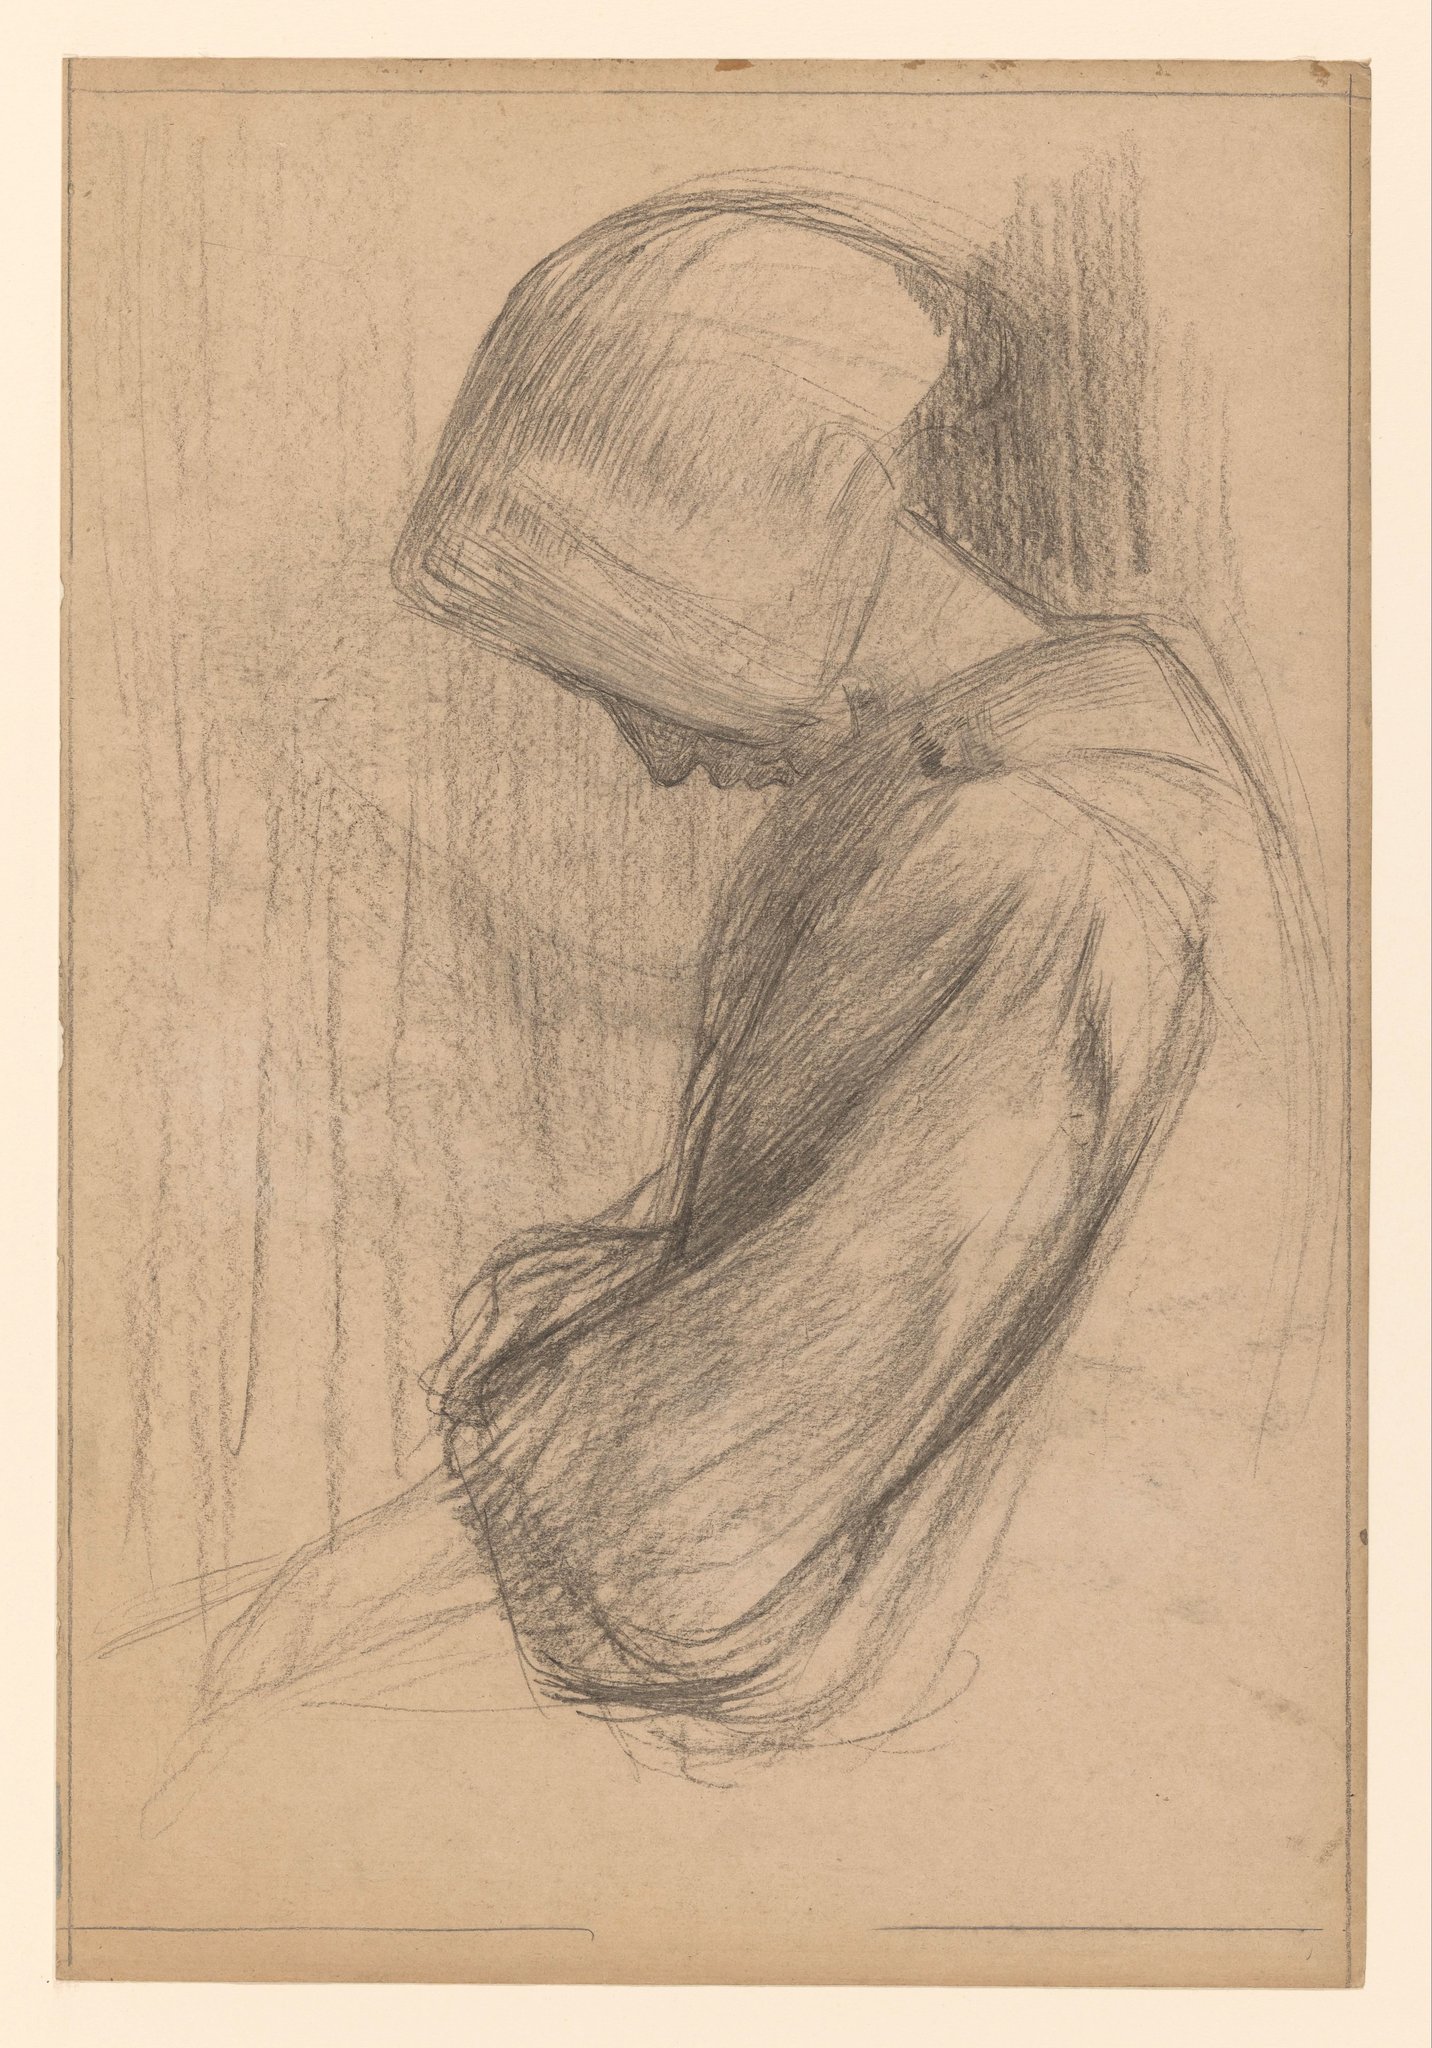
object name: drawing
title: Voorovergebogen zittende vrouw met kapje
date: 1874-1925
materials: chalk, paper